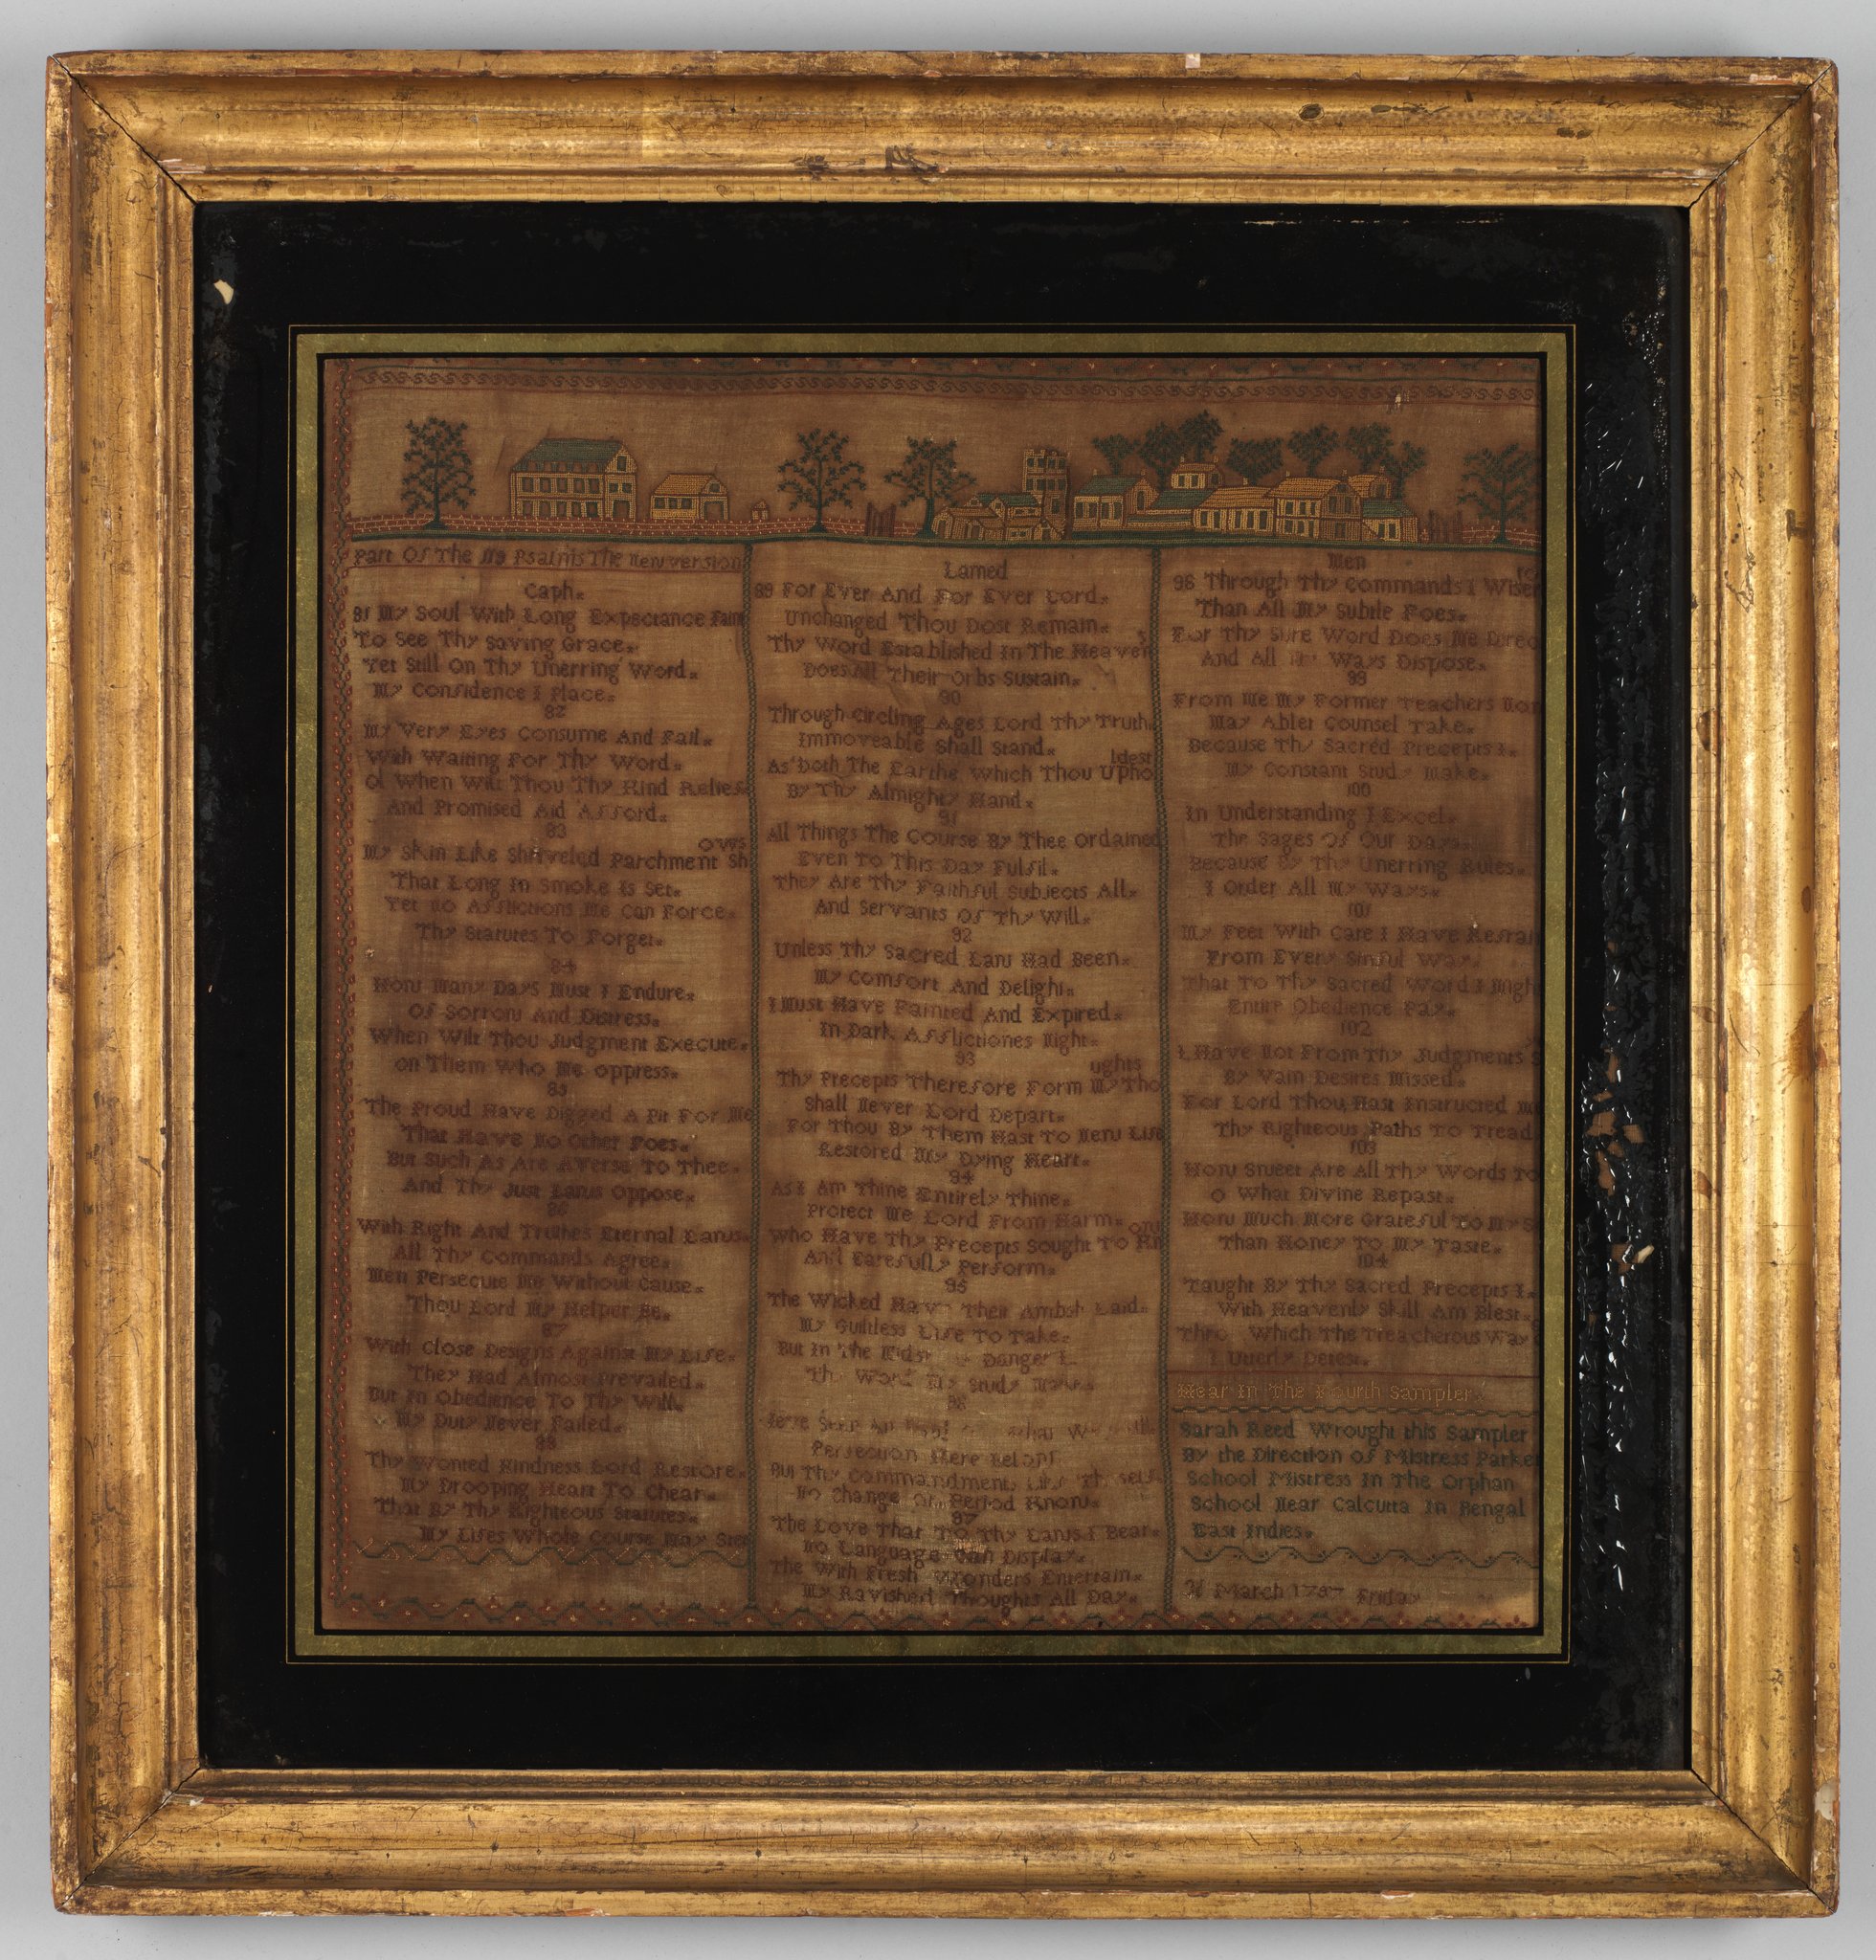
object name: sampler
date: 1797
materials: cotton, silk